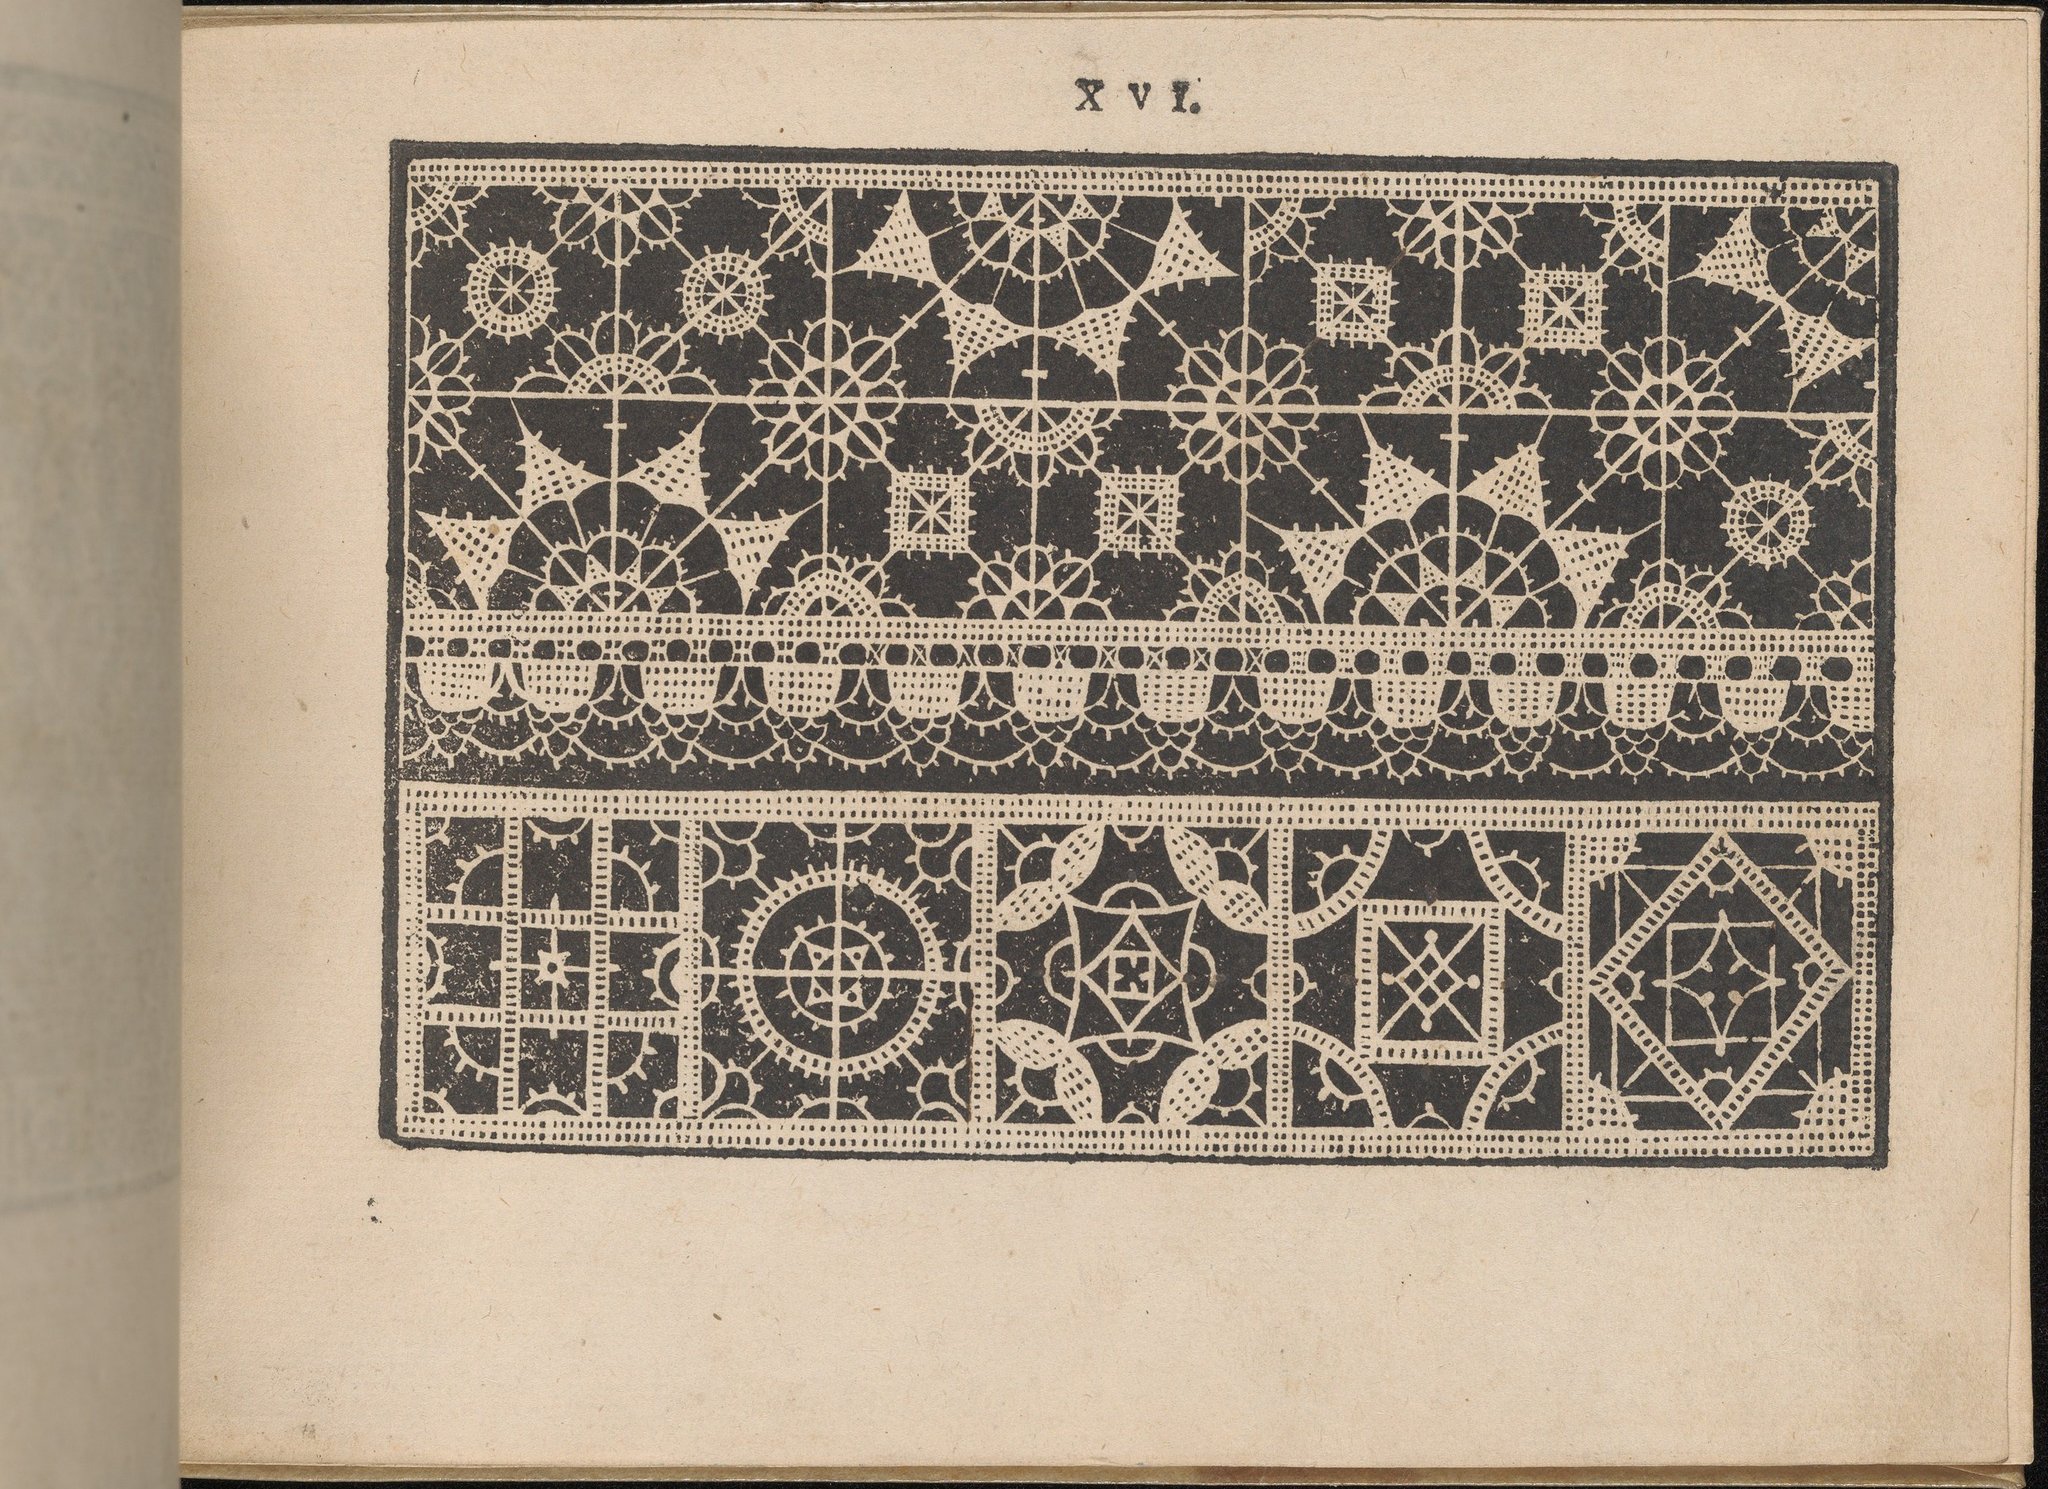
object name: book print ornament architecture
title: Prima Parte de' Fiori, e Disegni di varie sorti di Ricami Moderni, page 16 (recto)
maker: giovanni battista ciotti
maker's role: author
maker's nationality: italian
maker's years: 1555-1659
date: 1591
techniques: woodcut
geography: italy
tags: ornament